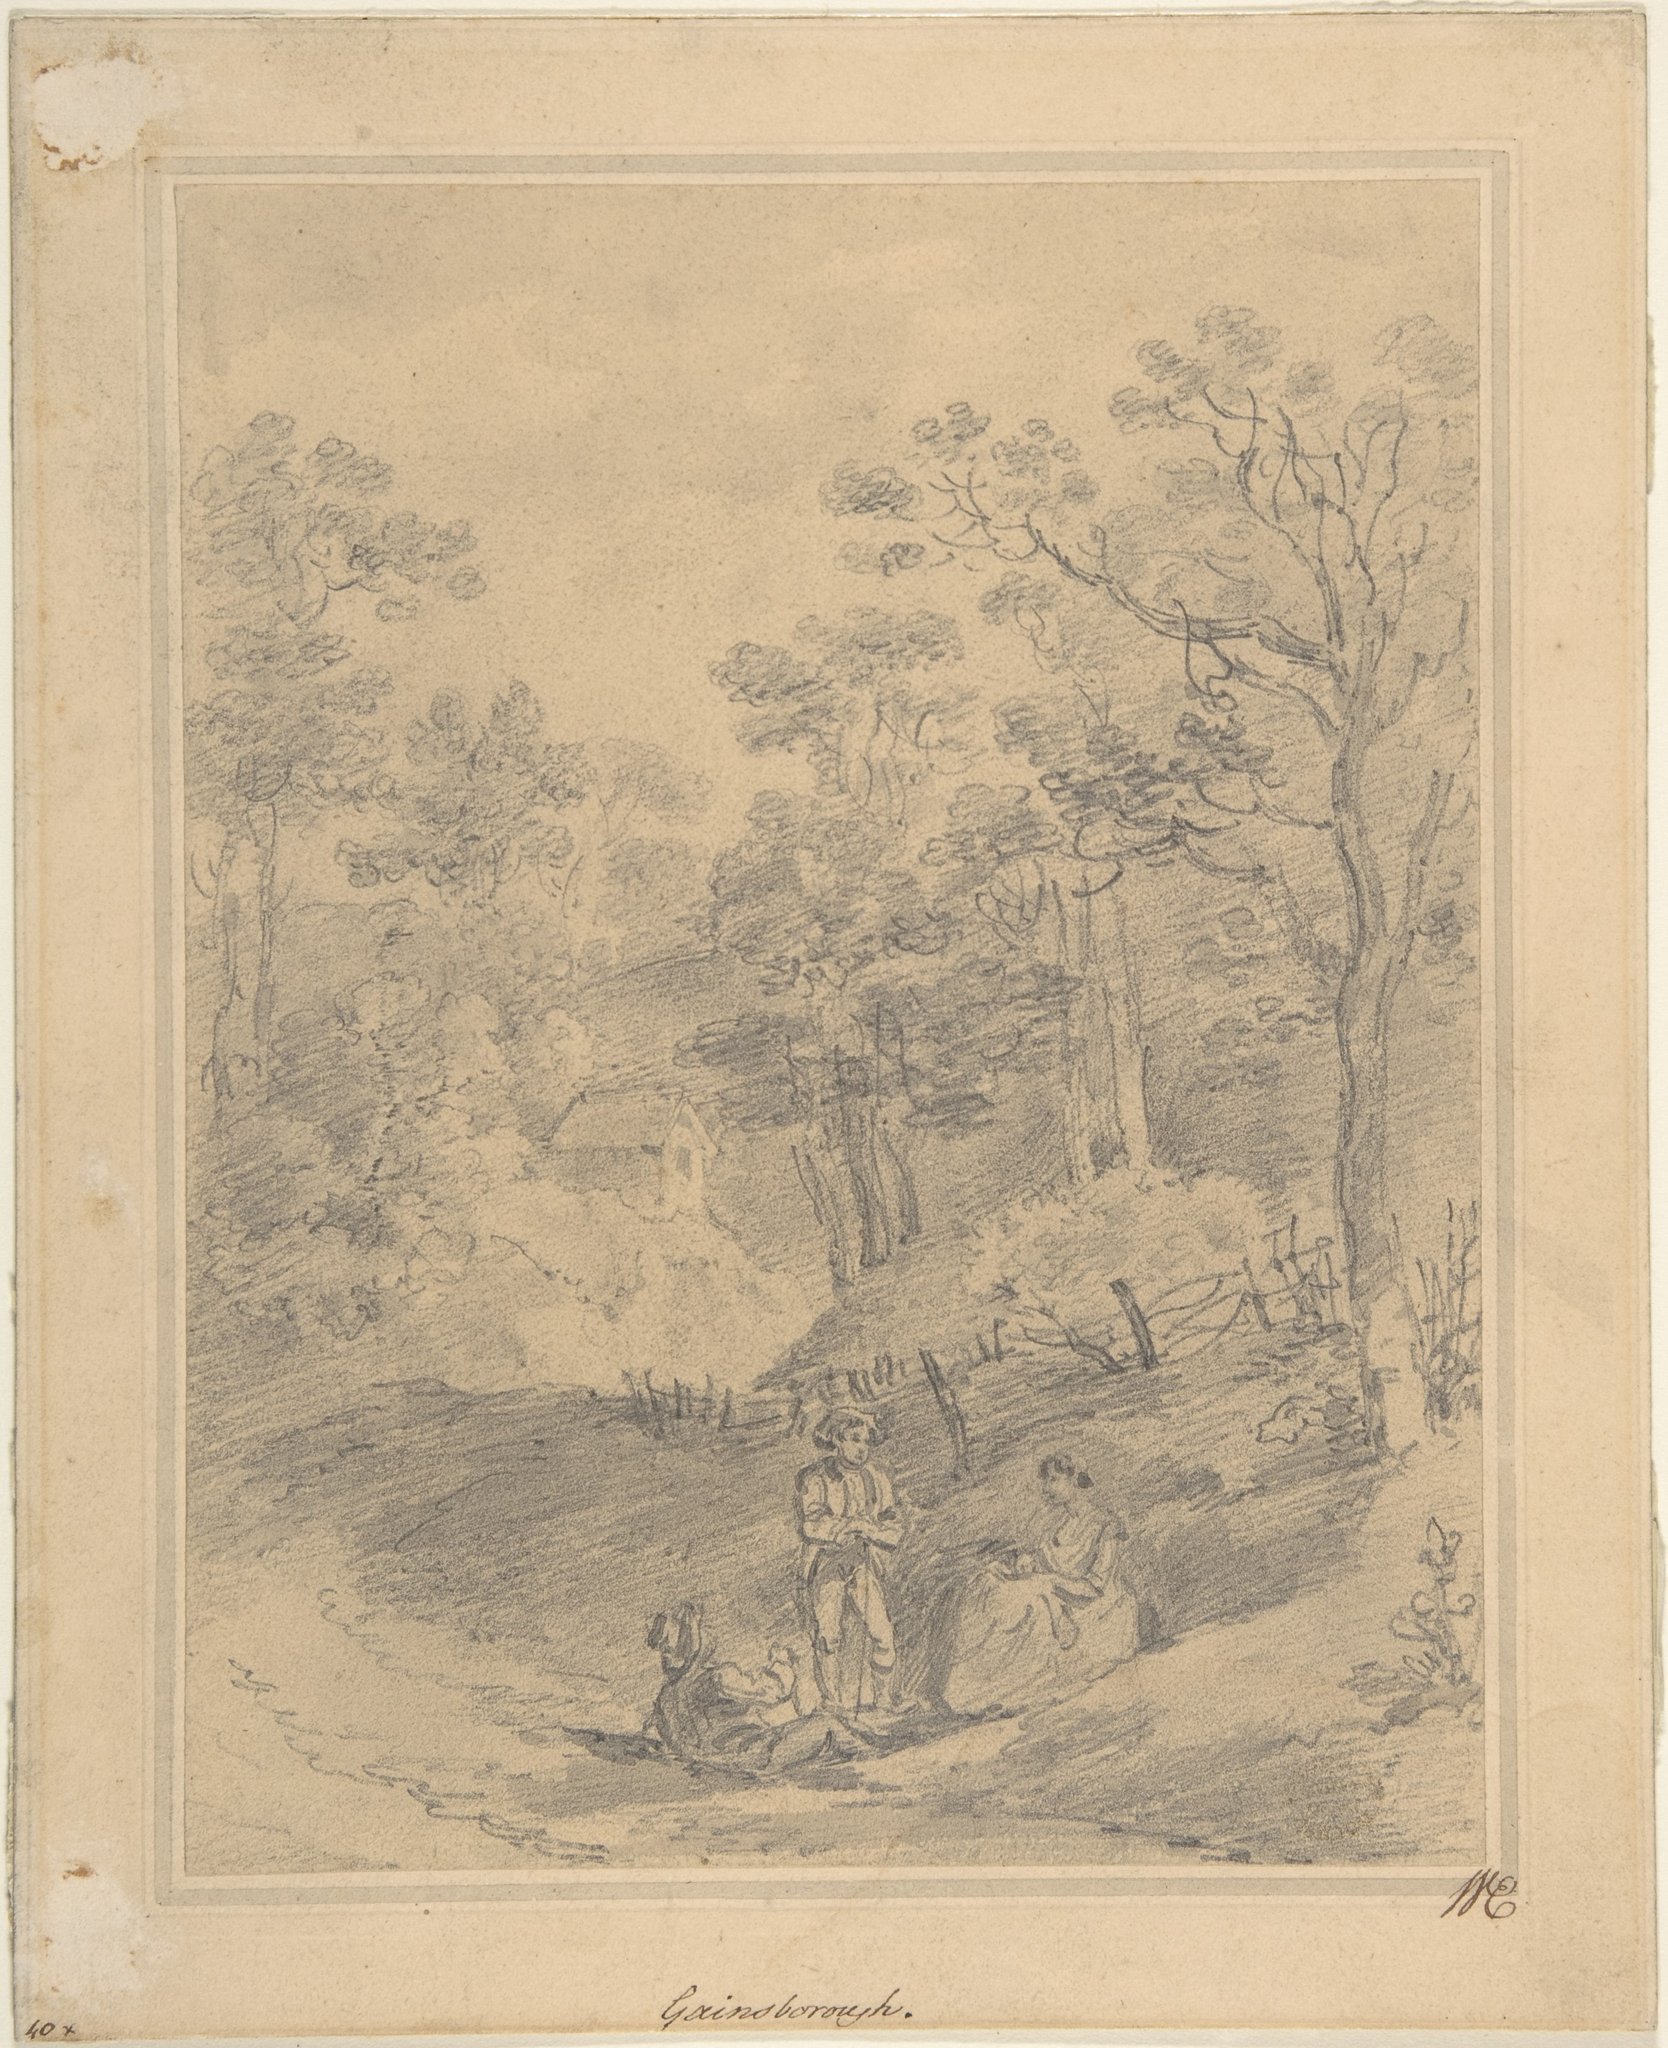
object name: drawing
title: Landscape with Figures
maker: george frost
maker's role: artist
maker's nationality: british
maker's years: 1745-1821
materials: graphite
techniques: brush, wash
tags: men,women,landscapes,trees